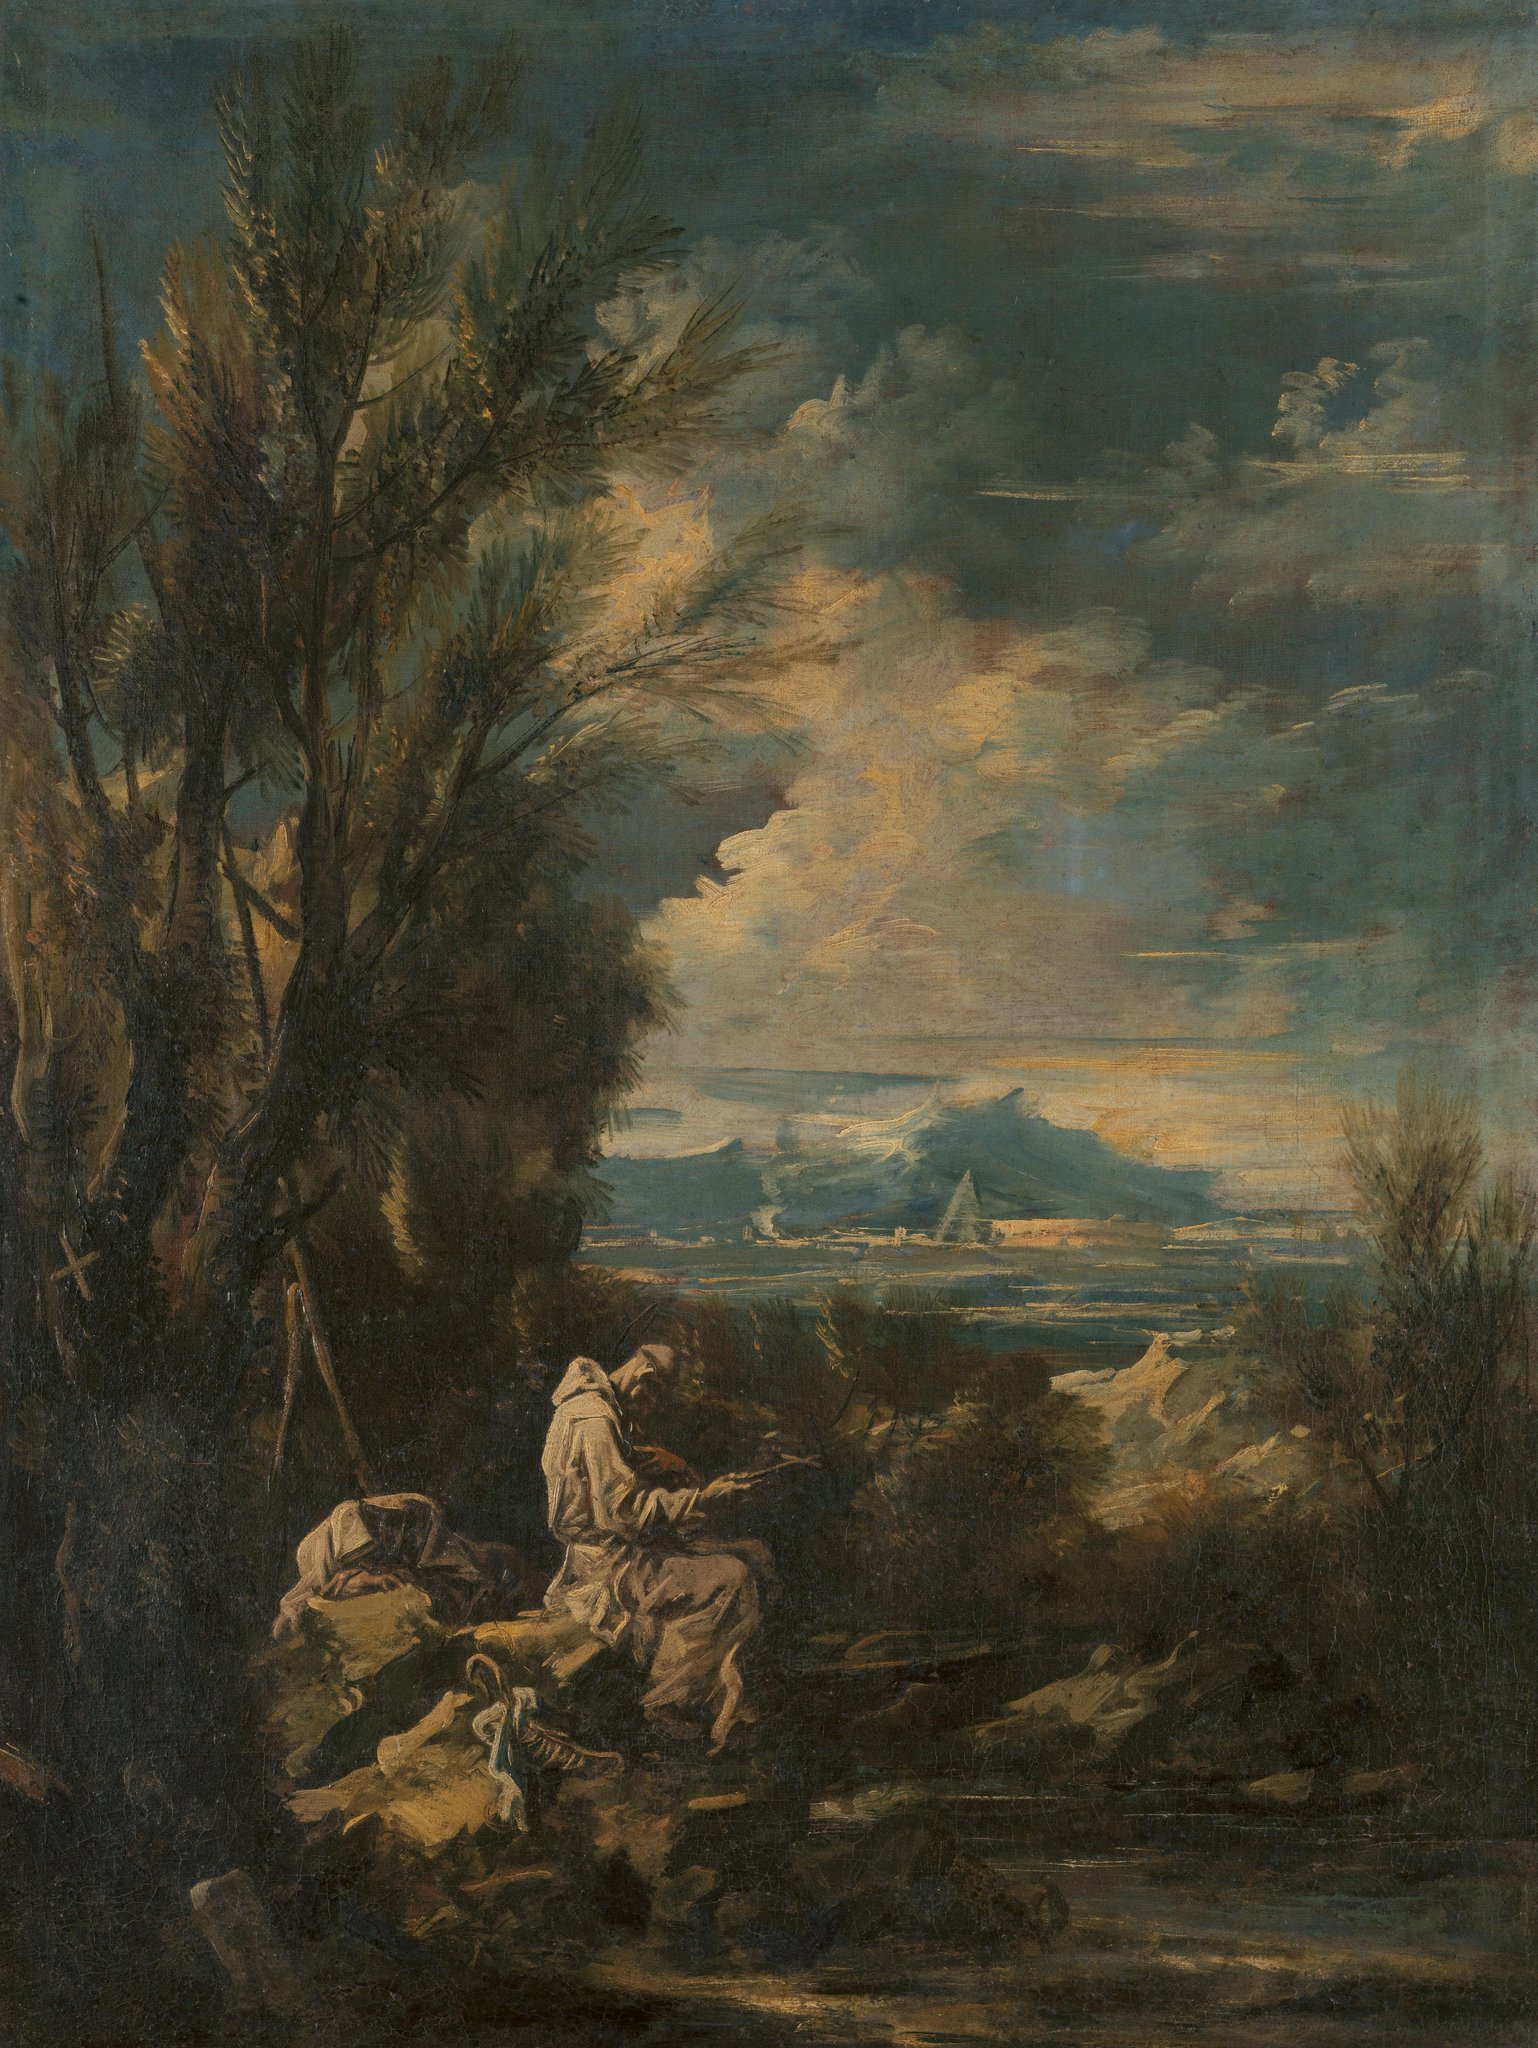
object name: painting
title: Landscape with Saint Bruno ?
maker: alessandro magnasco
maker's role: draughtsman, painter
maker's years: 1657-1749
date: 1700-1749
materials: canvas, oil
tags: the founder of the order of the carthusians, bruno; possible attributes: cross, finger at lips, lily, mitre at his feet, olive-branch, ray of light, skull, (seven) star(s)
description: Landschap met een karthuizer kluizenaar, wellicht de heilige Bruno. De heilige zit in een landschap aan de oever van een beek op rotsen in gebed verzonken met een kruis in de handen. Pendant van SK-A-3408.